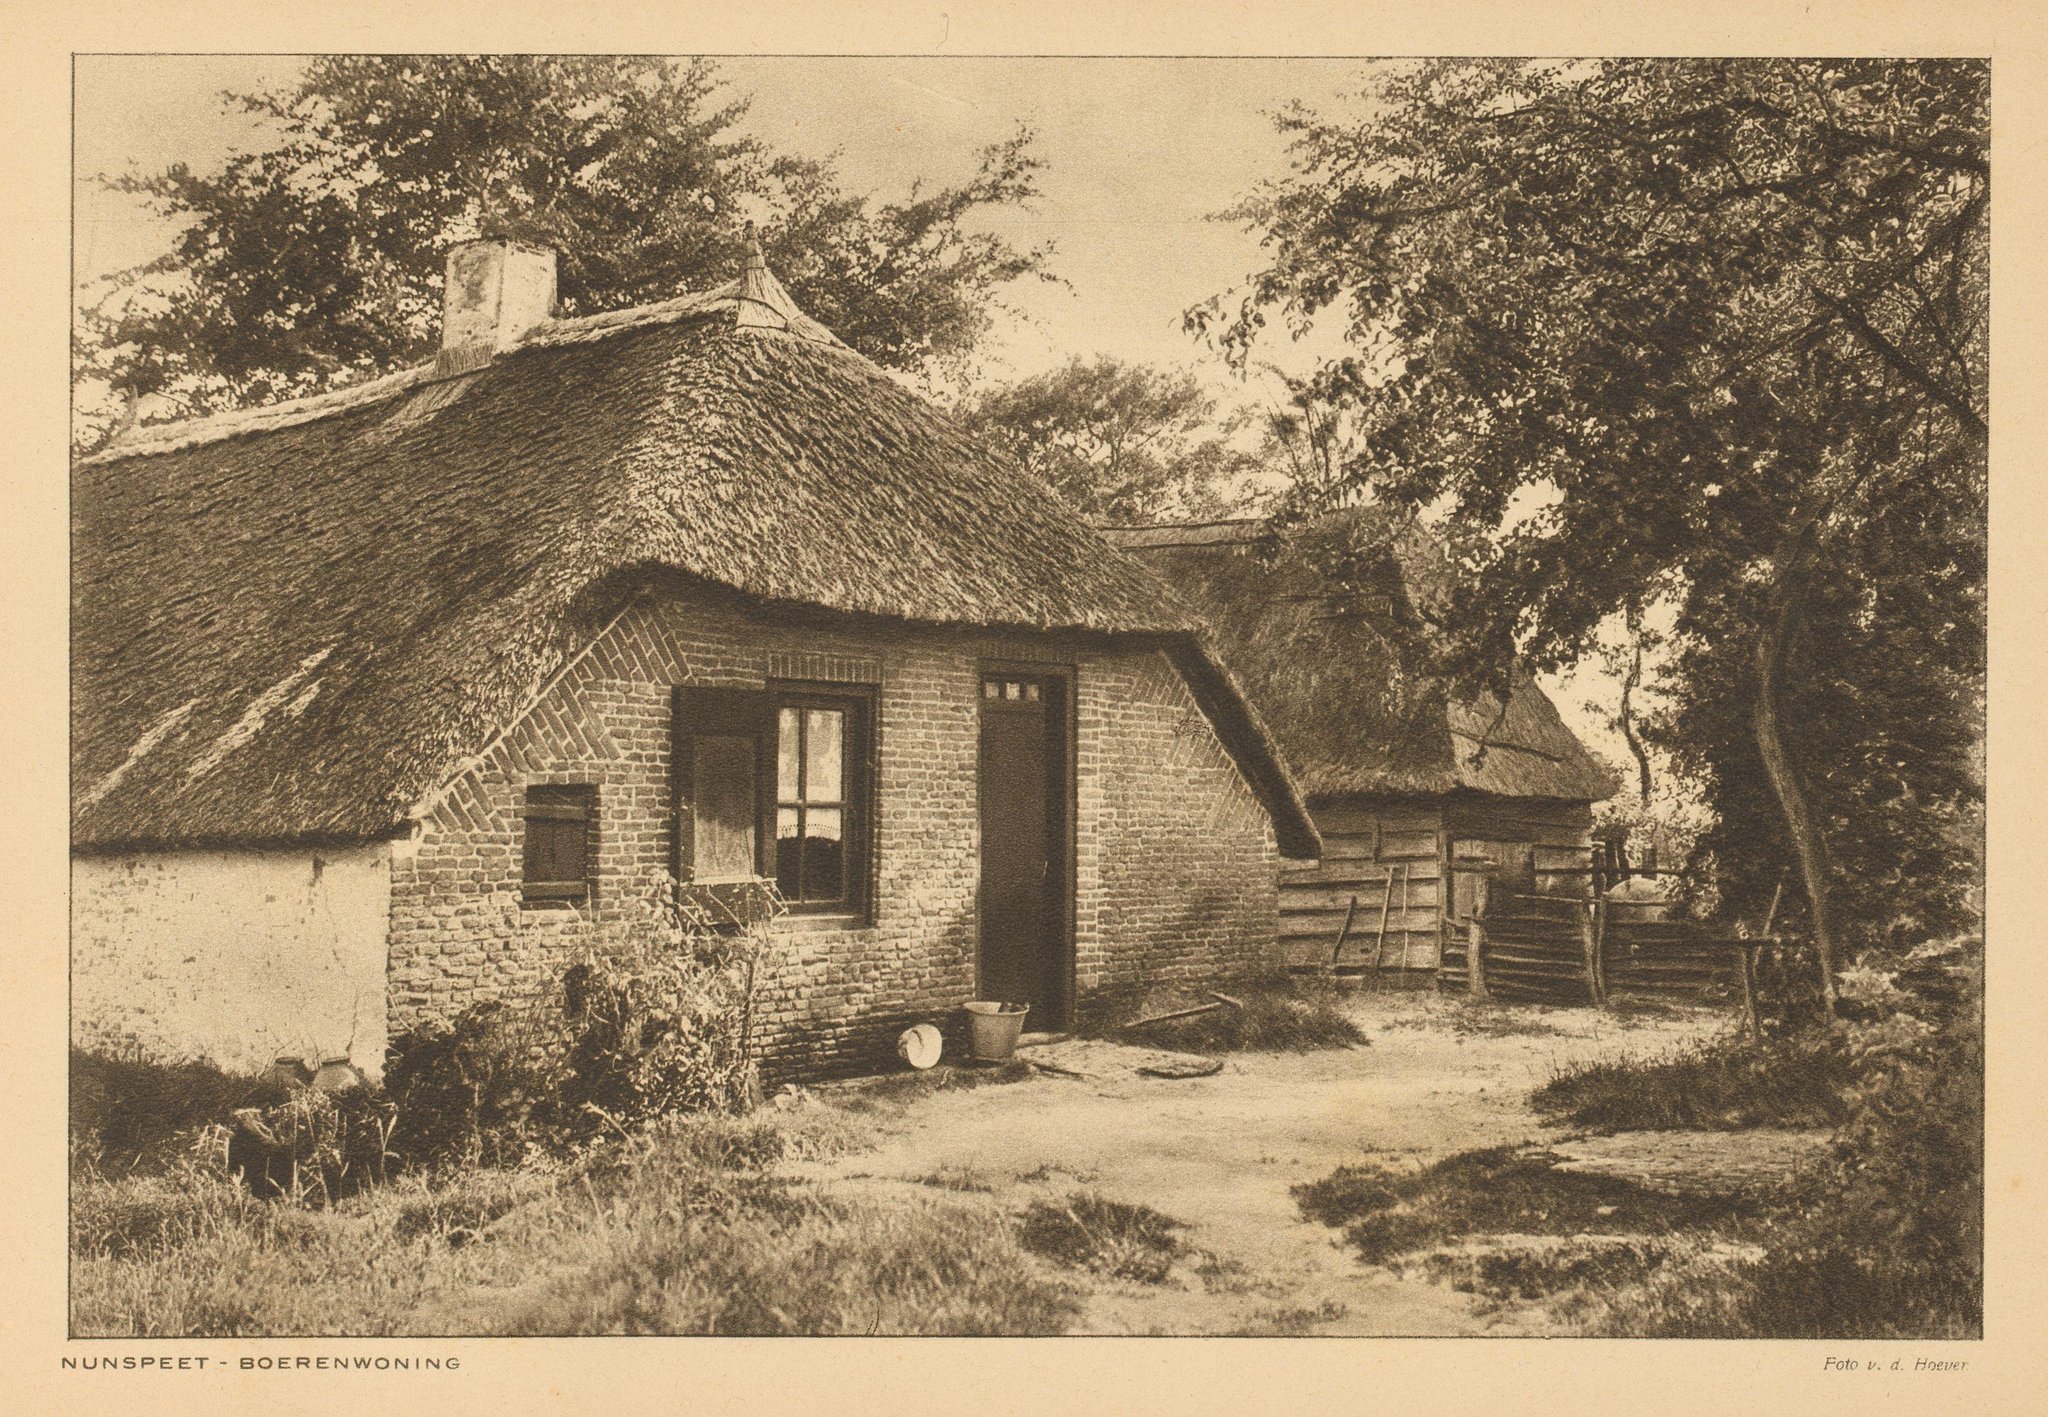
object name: photomechanical print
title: Nunspeet - boerenwoning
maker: v.d. hoeven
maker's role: fotograaf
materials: paper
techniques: rotogravure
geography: leiden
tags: farm (building)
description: Deze prent maakt deel uit van een album.